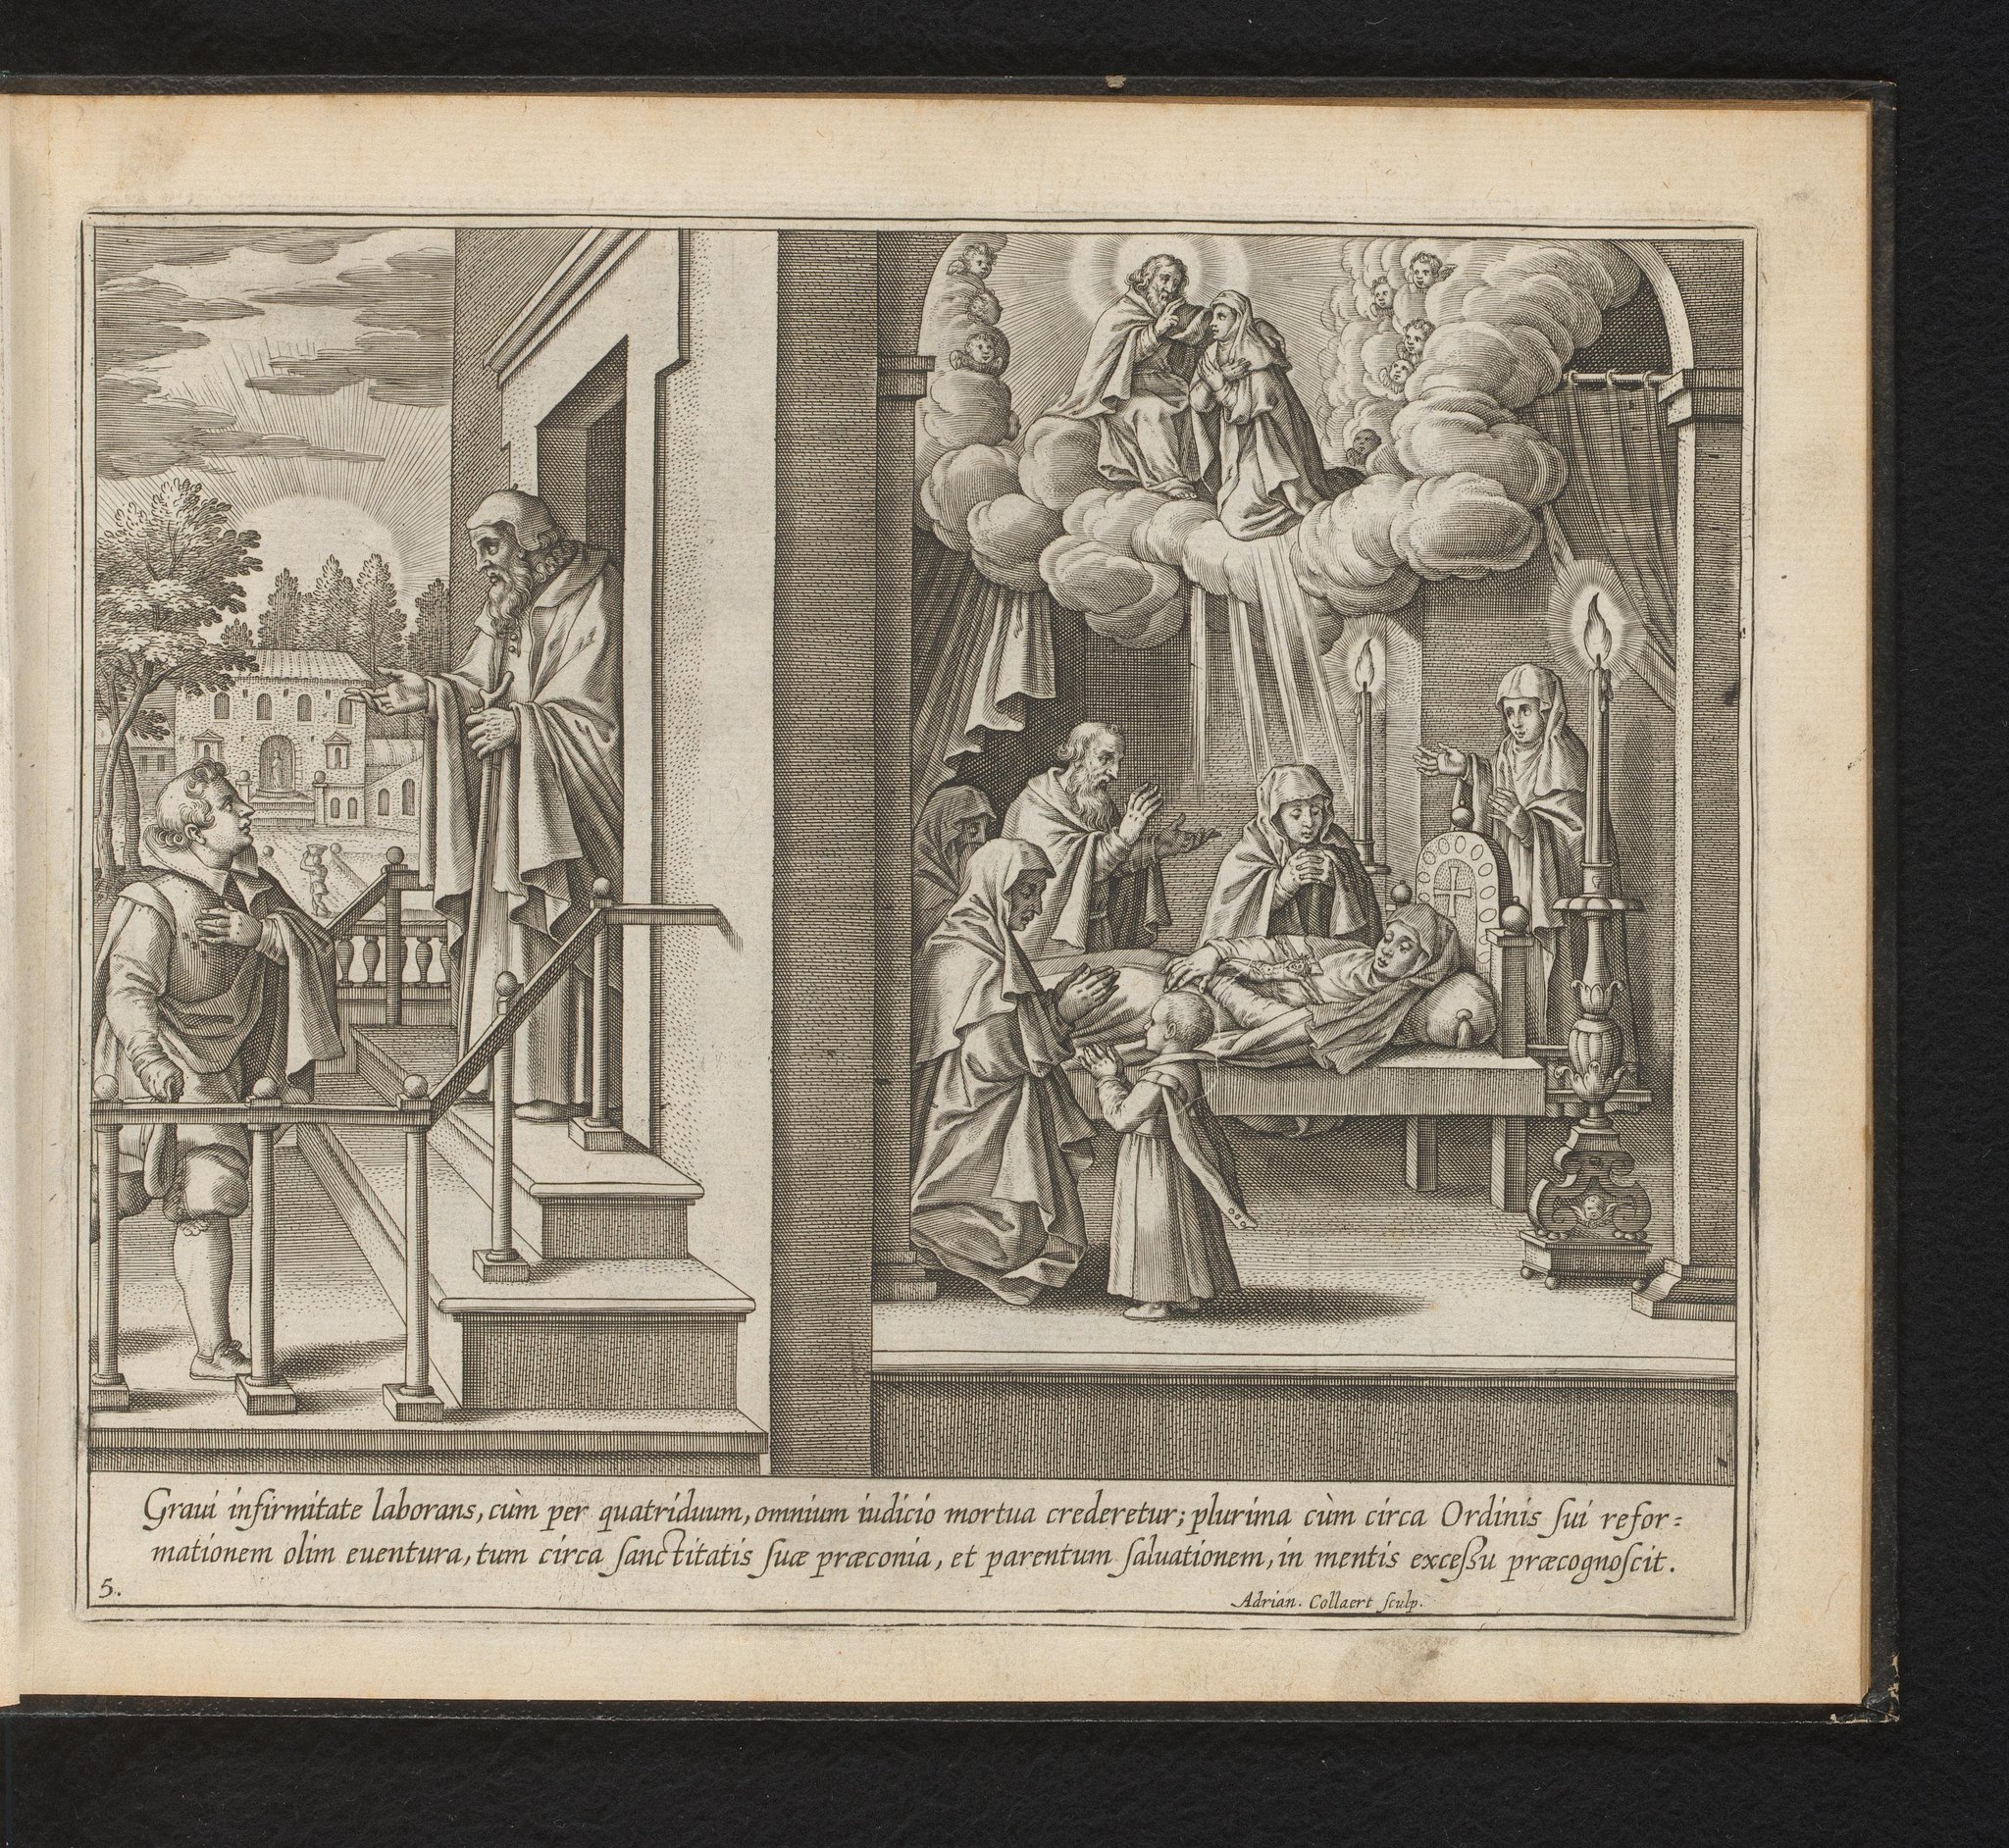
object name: print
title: Iedereen waant -onterecht- de door inspanning zeer verzwakte Teresa dood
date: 1613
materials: paper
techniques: engraving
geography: antwerp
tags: the foundress of the reformed (discalced) carmelites, t(h)eres(i)a of avila; possible attributes: angel, arrow, dove, heart (flaming or pierced by an arrow)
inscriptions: signature: ‘Adrian Collaert sculp.’, caption: ‘Gravi infirmitate...excessu praecognoscit.’, number: ‘5’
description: Prent in album 'Vita B. Virginis Teresiae A. Jesu ordinis carmelitarum excalceatorum piae restauratricis..., 1613.